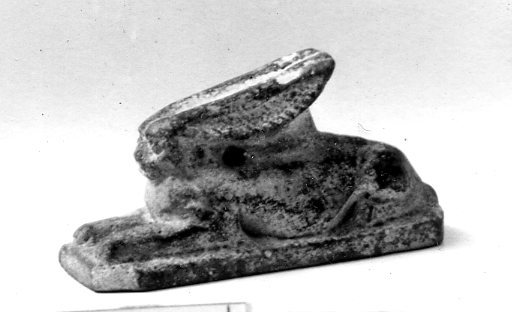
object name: amulet, hare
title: Hare amulet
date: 664-332 BCE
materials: faience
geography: egypt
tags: animals